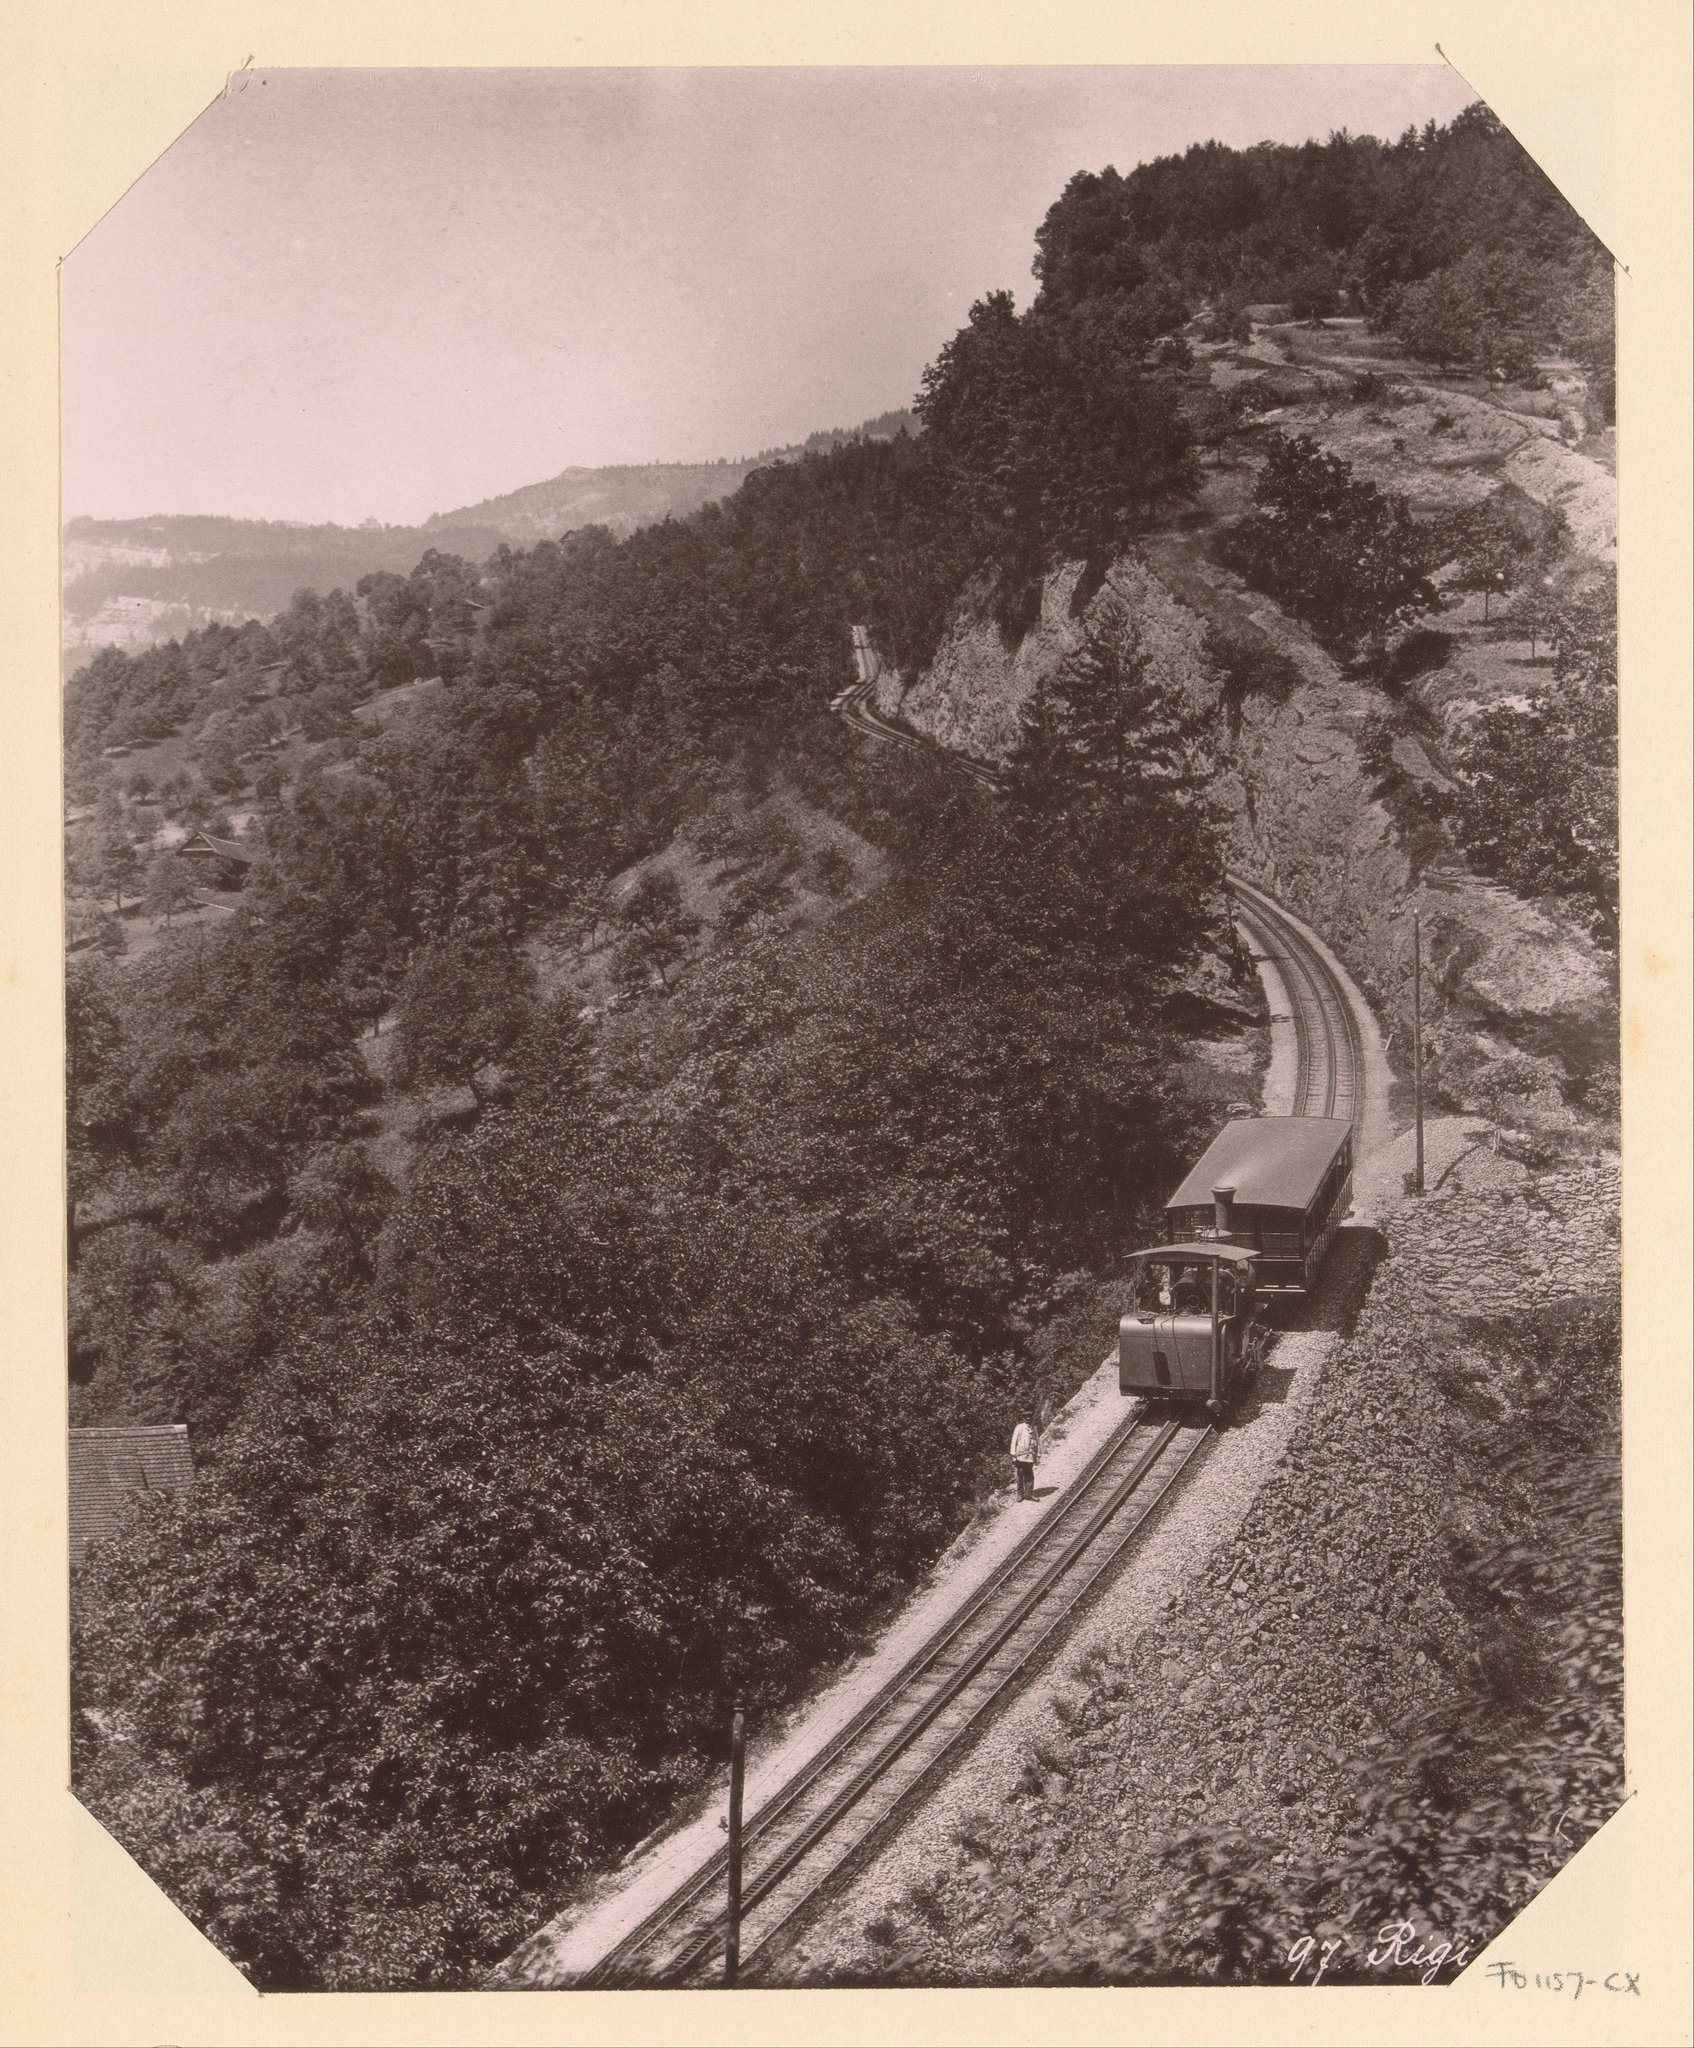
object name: photograph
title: Rigi Bahn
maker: Anonymous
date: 1885-1892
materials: photographic support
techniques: albumen print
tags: railway, train, mountains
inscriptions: number: ‘97’, annotation: ‘Rigi-spoorweg’